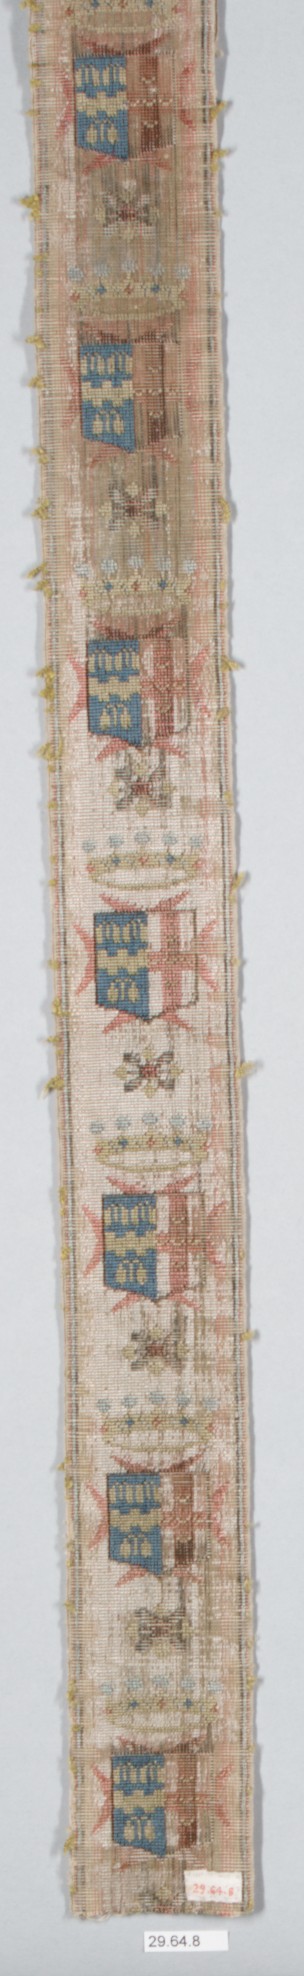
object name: galloon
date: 1701-1900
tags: coat of arms